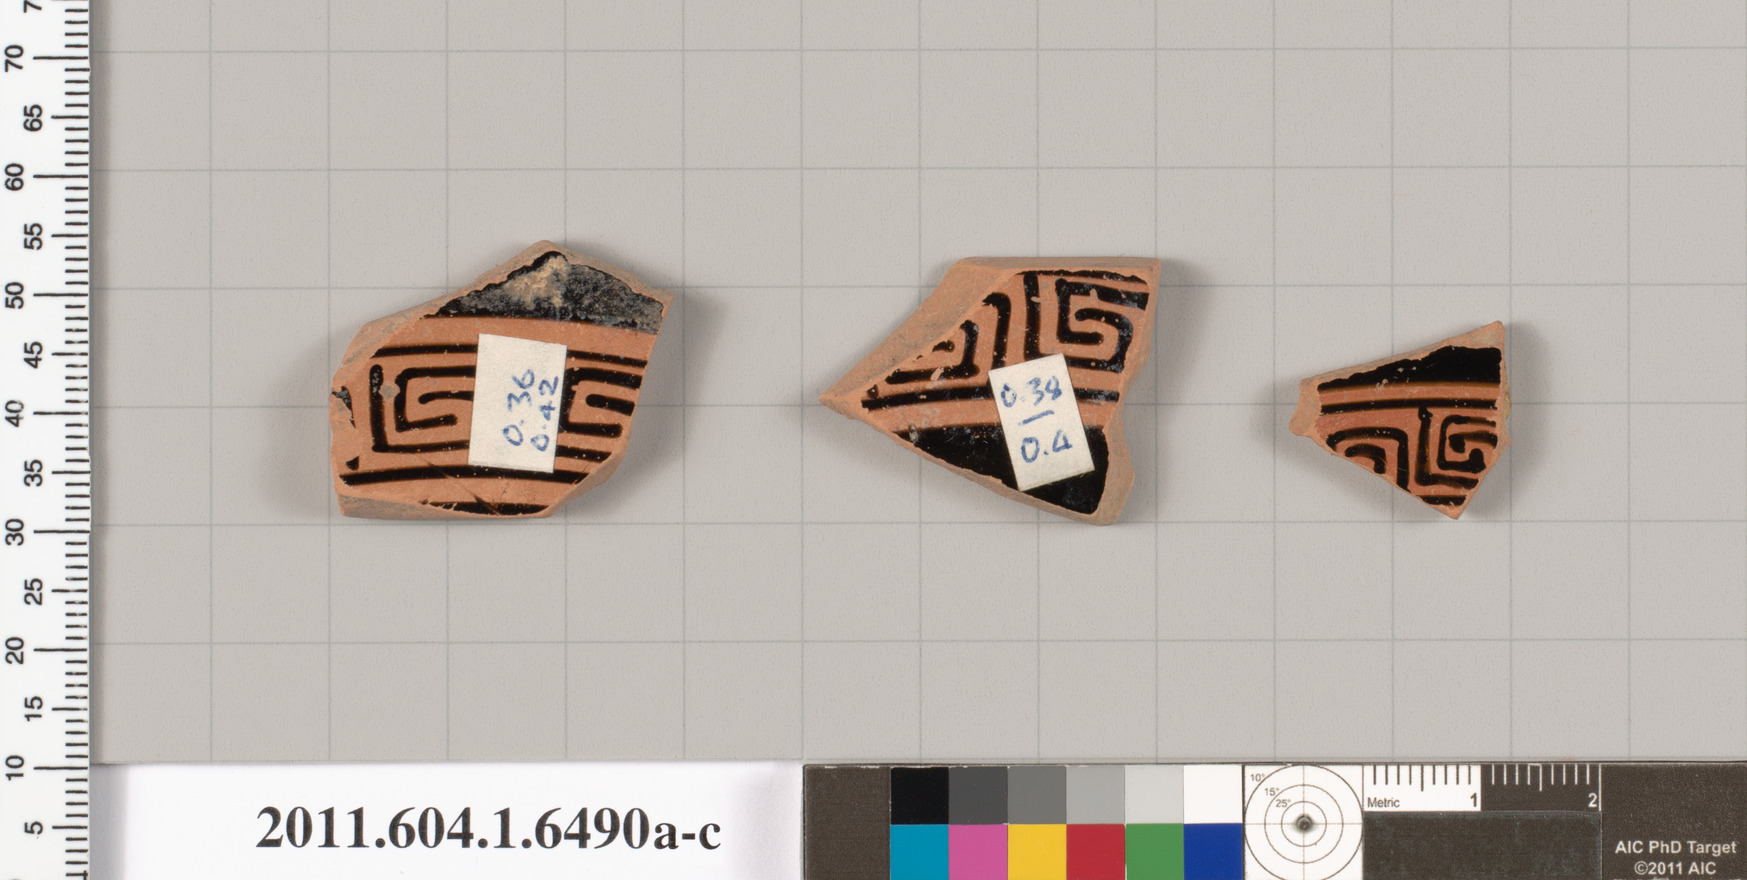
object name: kylix fragment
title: Terracotta fragment of a kylix (drinking cup)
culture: greek, attic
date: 490-480 BCE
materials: terracotta